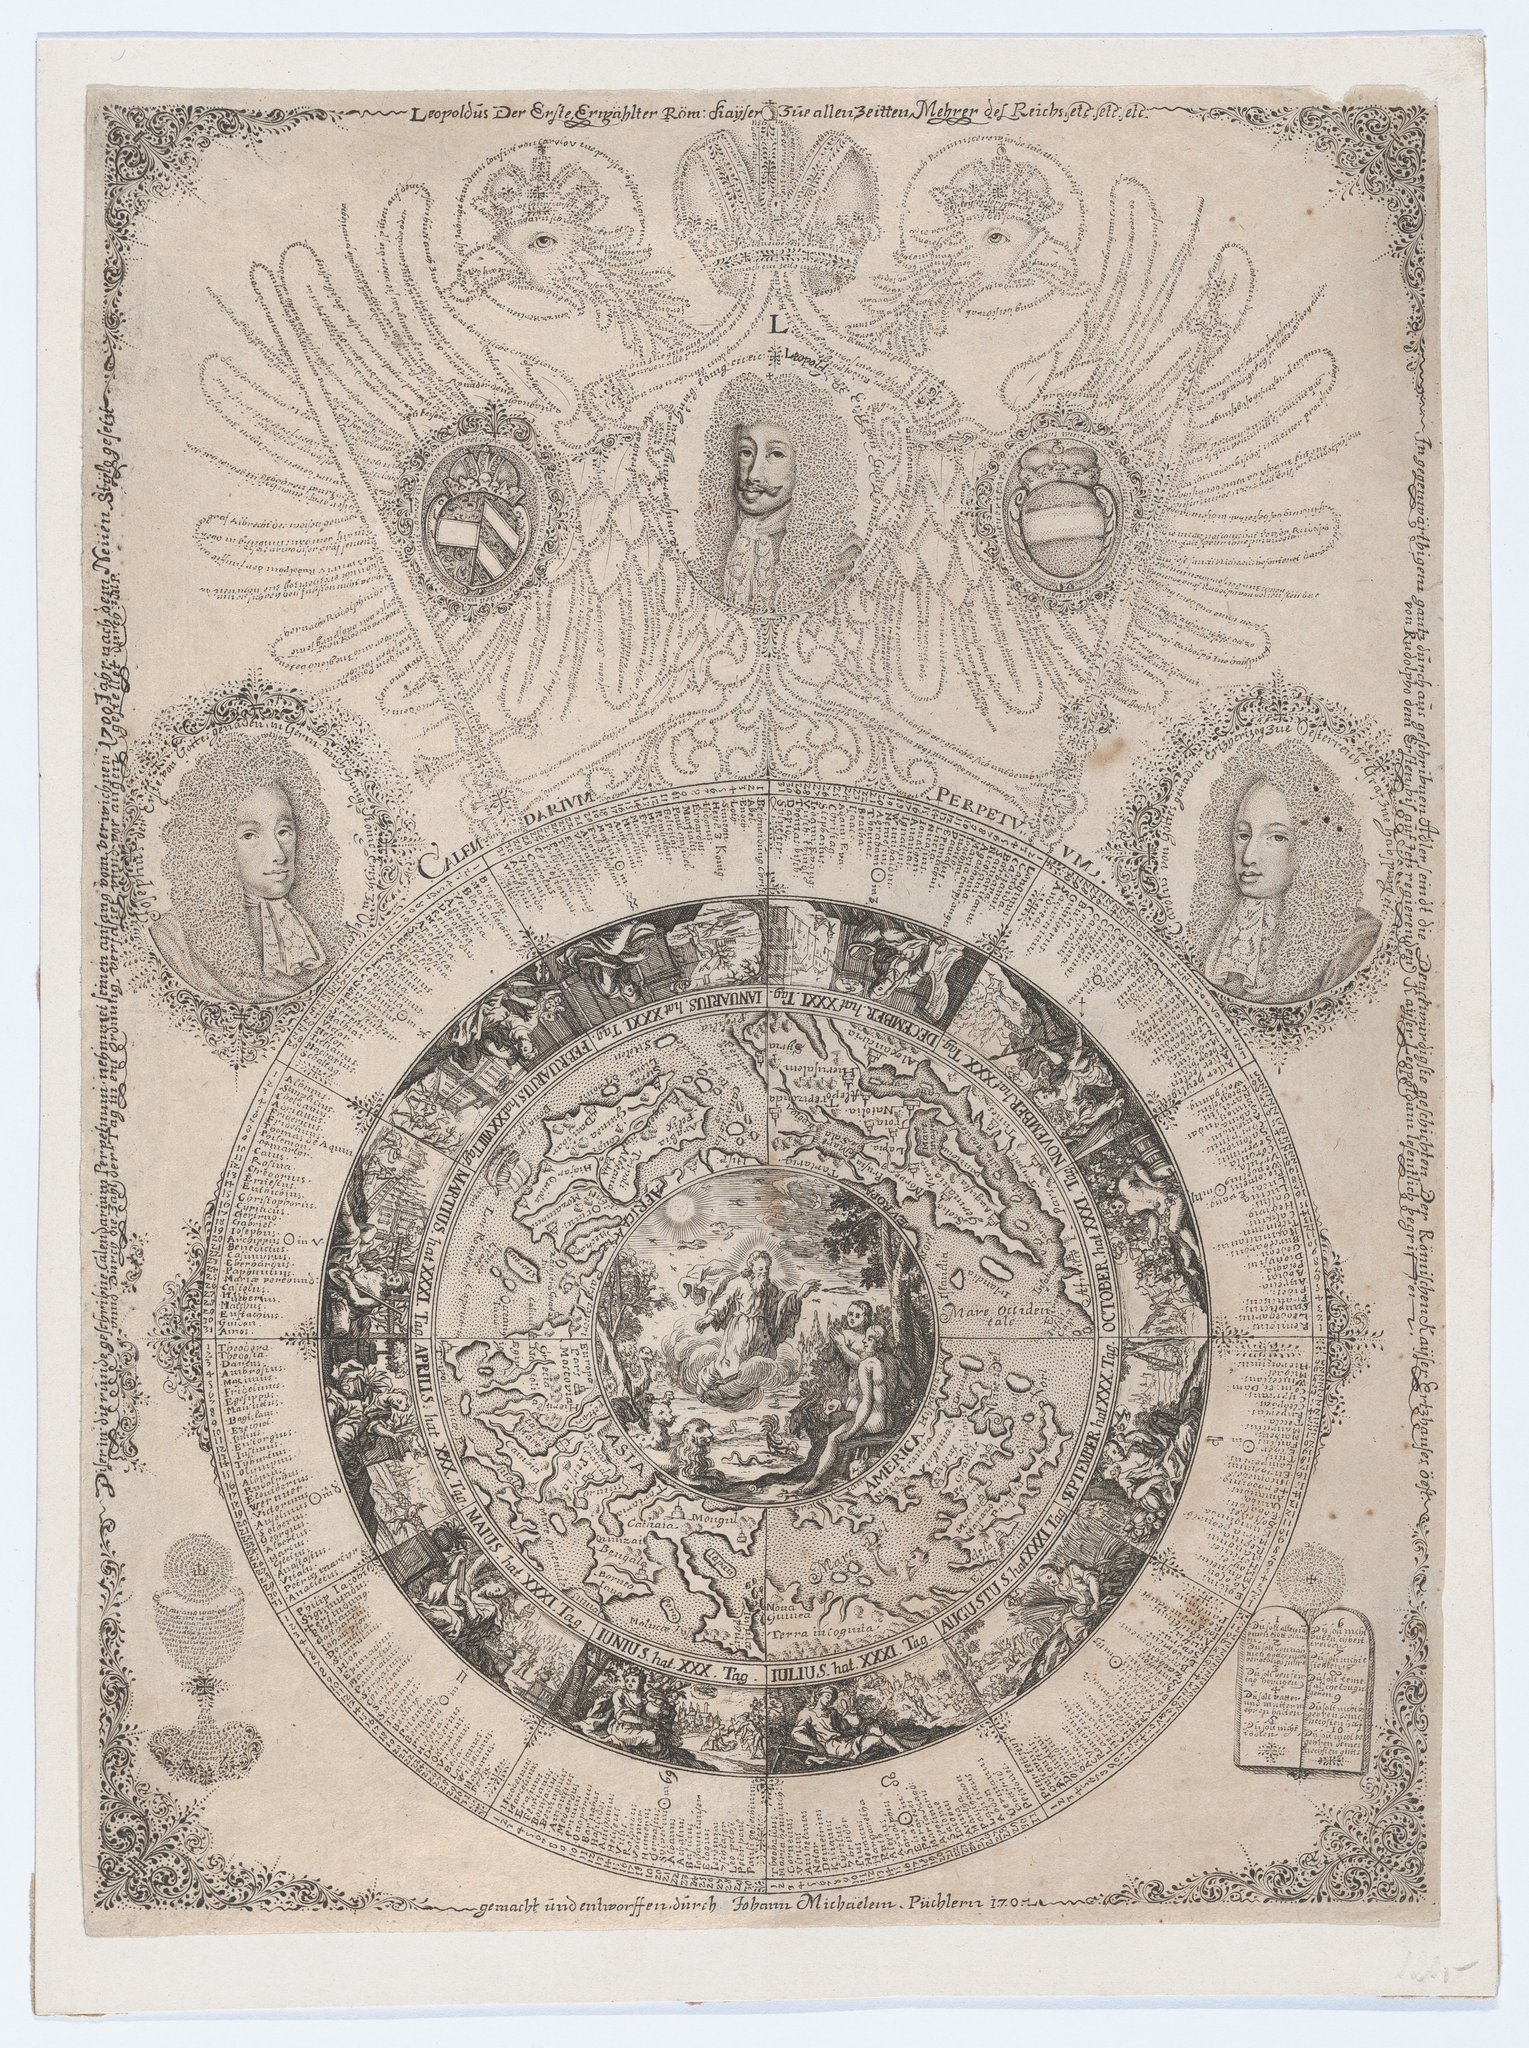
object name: print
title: The Perpetual Calendar with Portraits of Leopold I and his sons Joseph and Charles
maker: johann michael püchler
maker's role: artist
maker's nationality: german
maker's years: 1675-1702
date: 1702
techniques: engraving